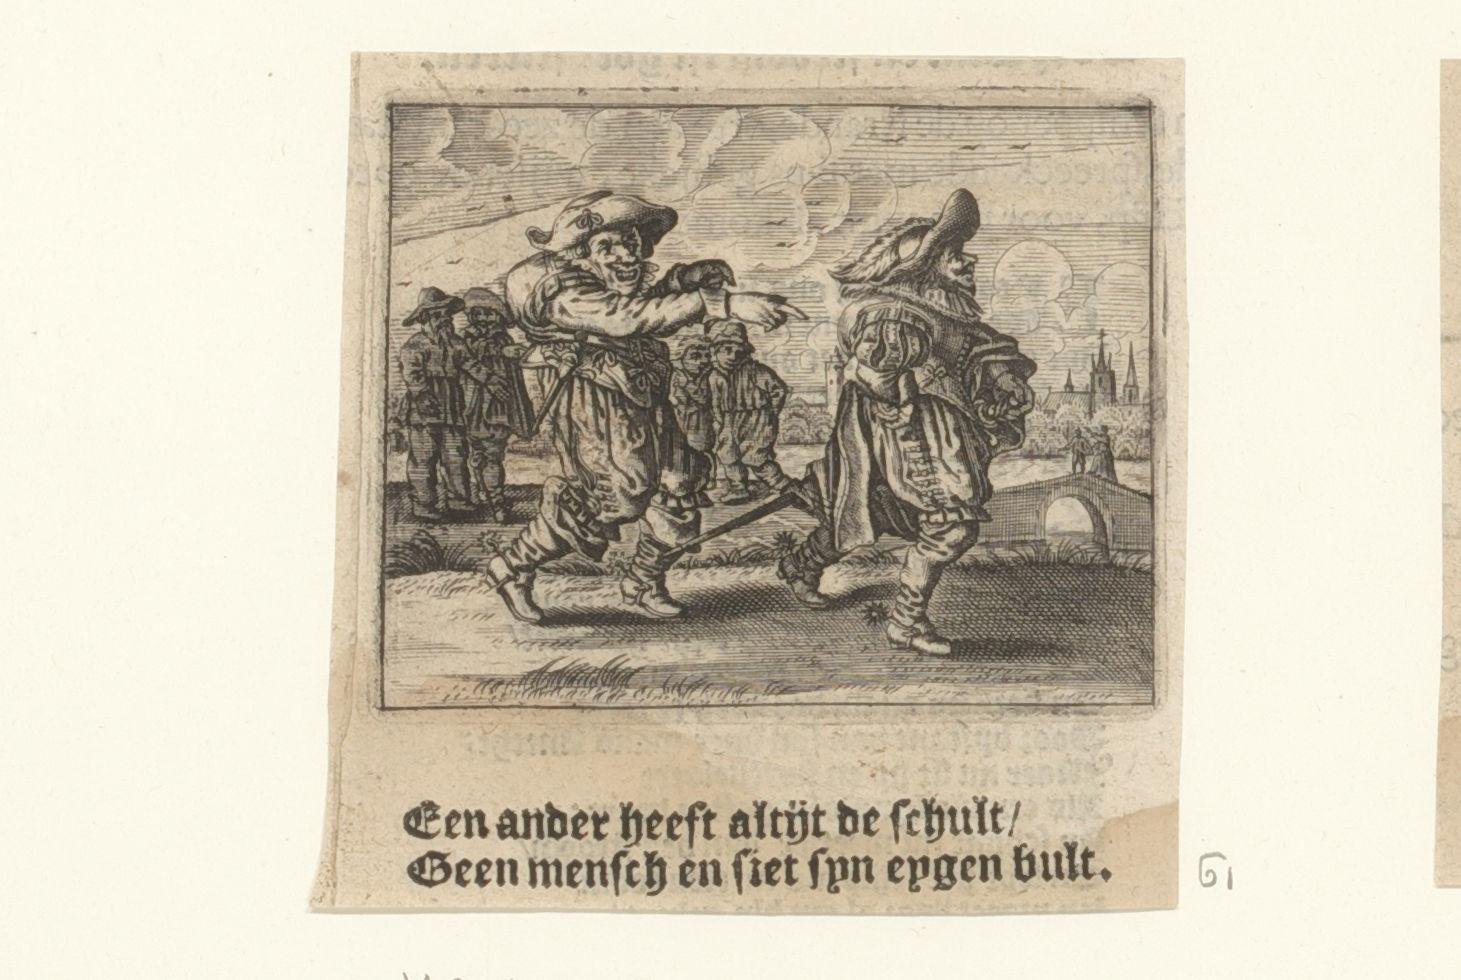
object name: book illustration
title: Een man loopt lachend achter een andere man aan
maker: Anonymous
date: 1635-1715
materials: paper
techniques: engraving, letterpress printing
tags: laughing, proverbs, sayings, etc.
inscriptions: stamp, collector's mark: Lugt 1641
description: Veel versies van dit embleem verschenen in verschillende uitgave van Spiegel van den Ouden ende Nieuwen Tydt. Zoals: Cats, Jacob. Spiegel van den Ouden ende Nieuwen-tijt, Bestaende uyt Spreeck-woorden (...). Dordrecht: Jacob Braat, 1647. Maar ook in andere publicaties (1665, 1671, 1715, 1722).